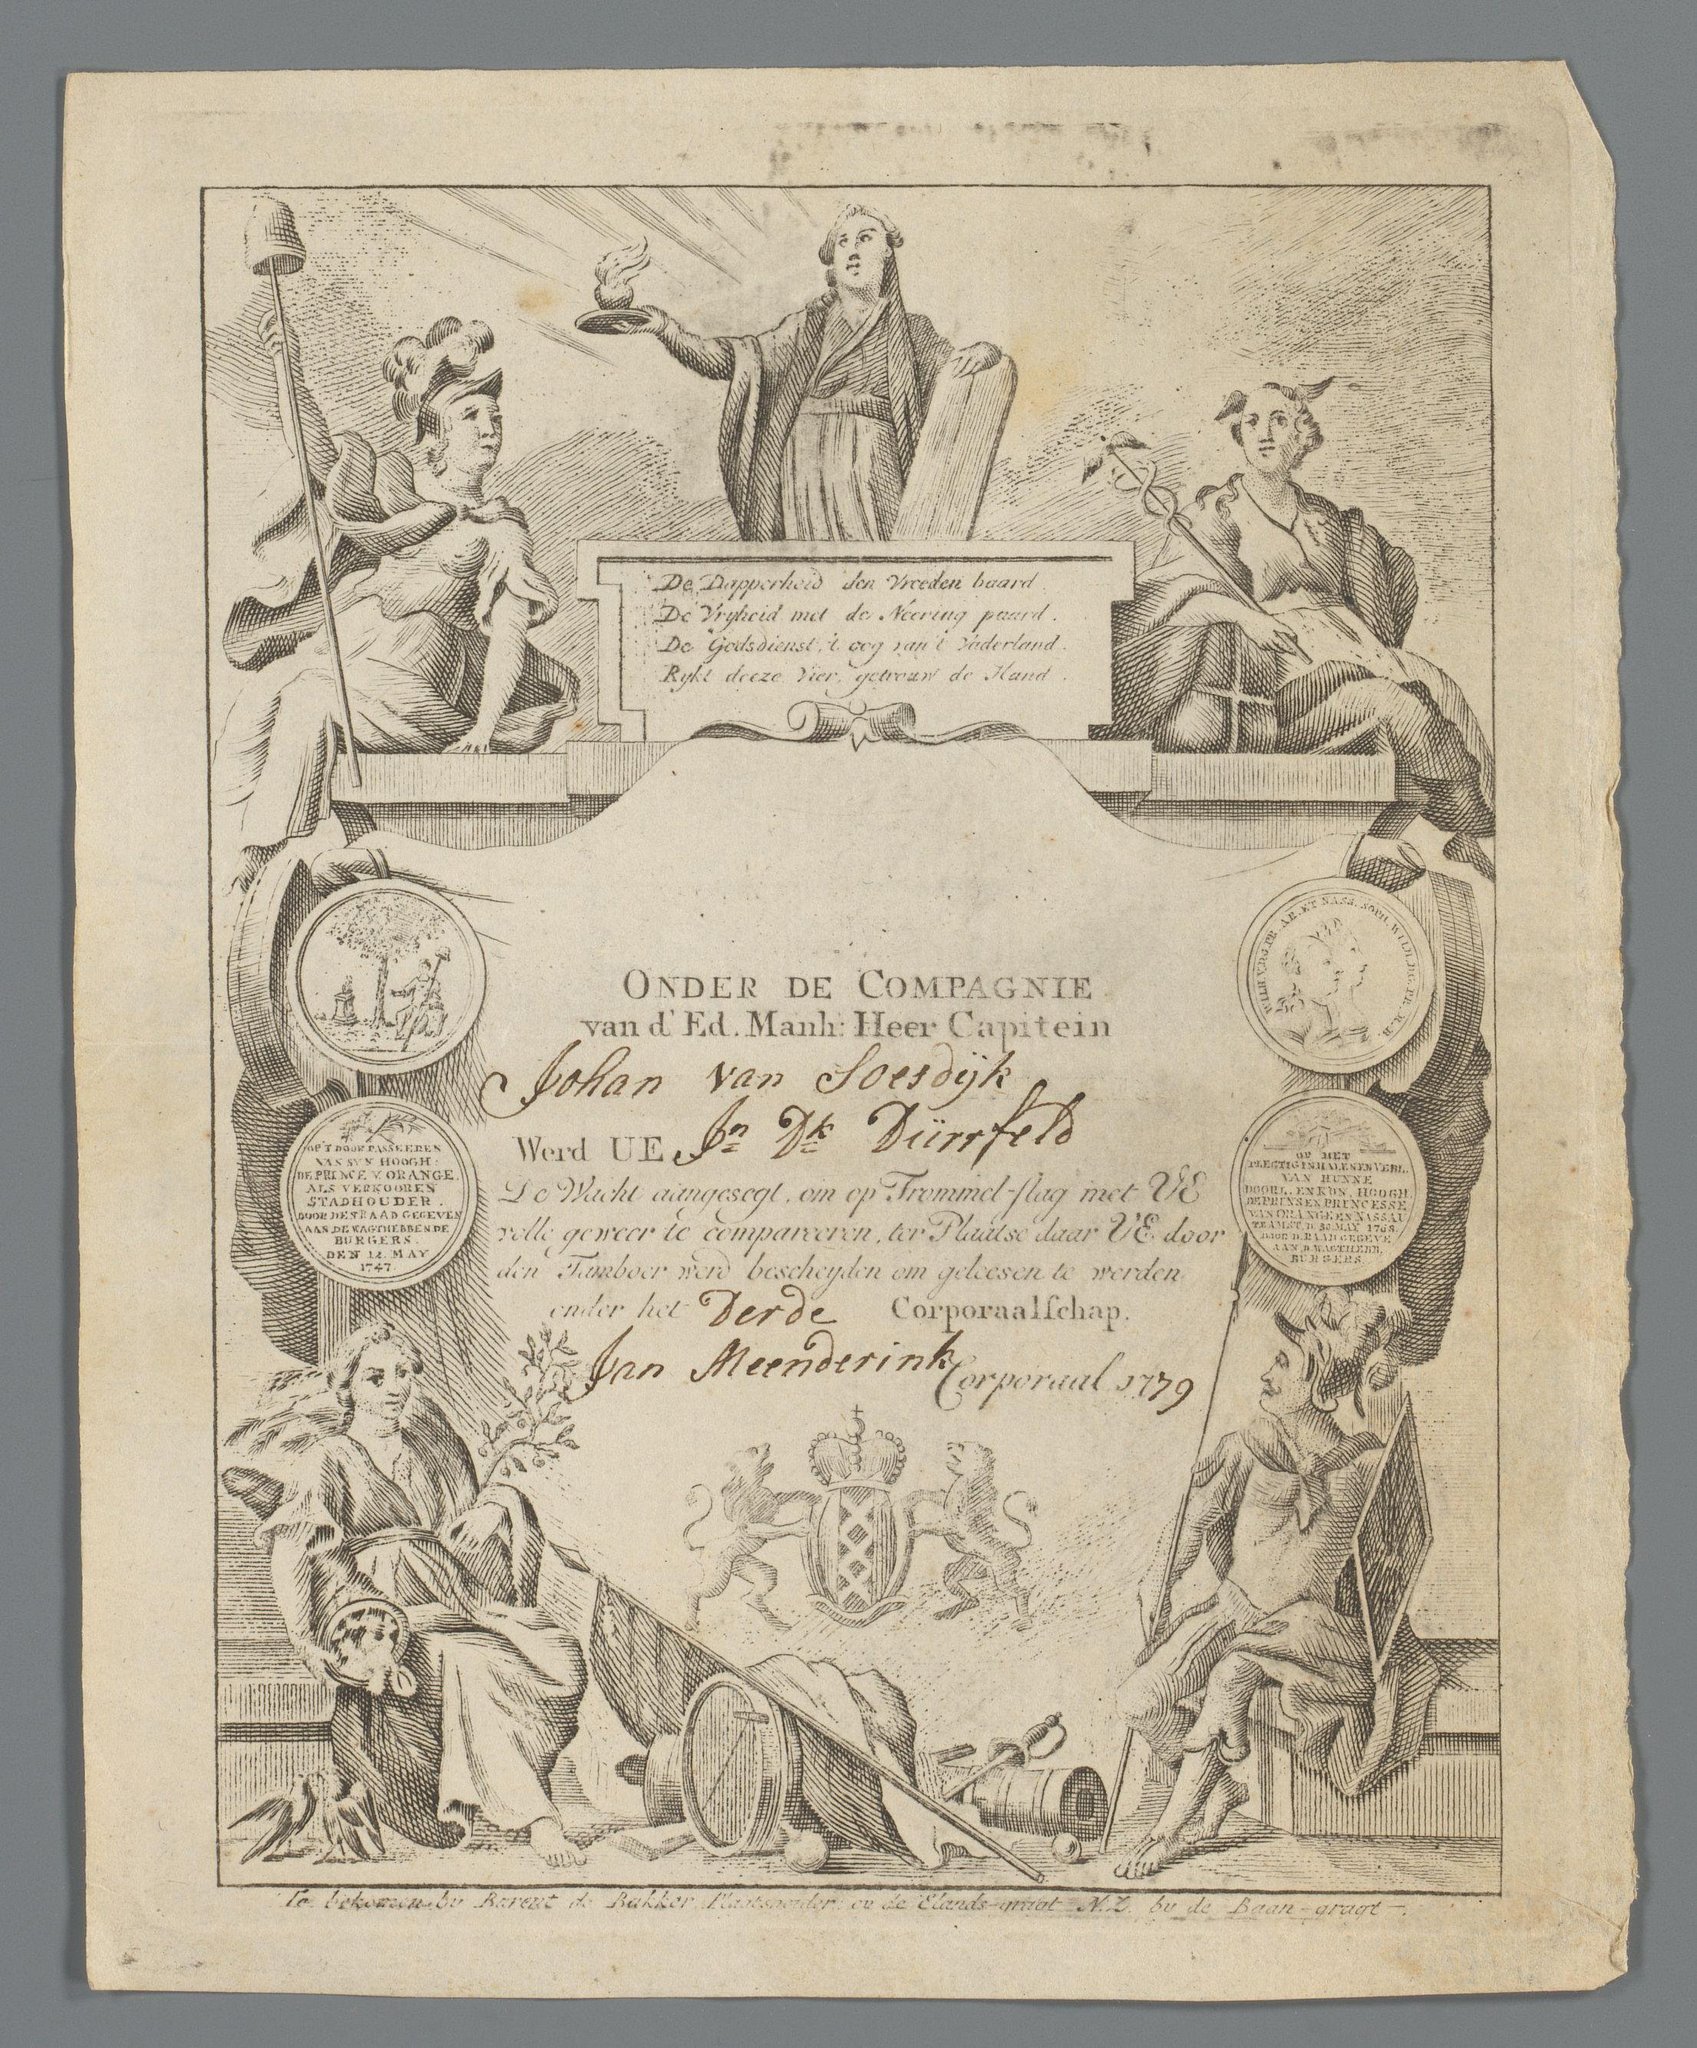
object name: schuttersbiljet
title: Schuttersbrief van kapitein Johan van Soesdijk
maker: barent de bakker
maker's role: print maker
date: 1779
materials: ink, paper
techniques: engraving, etching, pen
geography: amsterdam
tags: allegory, personification of good government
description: Met de tekst: 'Onder de Compagnie van d'Ed. Manh. Heer Capitein [Johan van Soesdijk] werd UE [Jn. Dk. Dürrfeld] De Wacht aangesegt, om op Trommel-slag met UE volle geweer te compareeren, ter Plaatse daar UE door den Tamboer werd bescheyden om geleesen te werden onder het [Derde] Corporaalschap [Jan Steenderink] Corporaal 17[79]'. (De delen tussen rechte haken werden met de hand ingevuld).